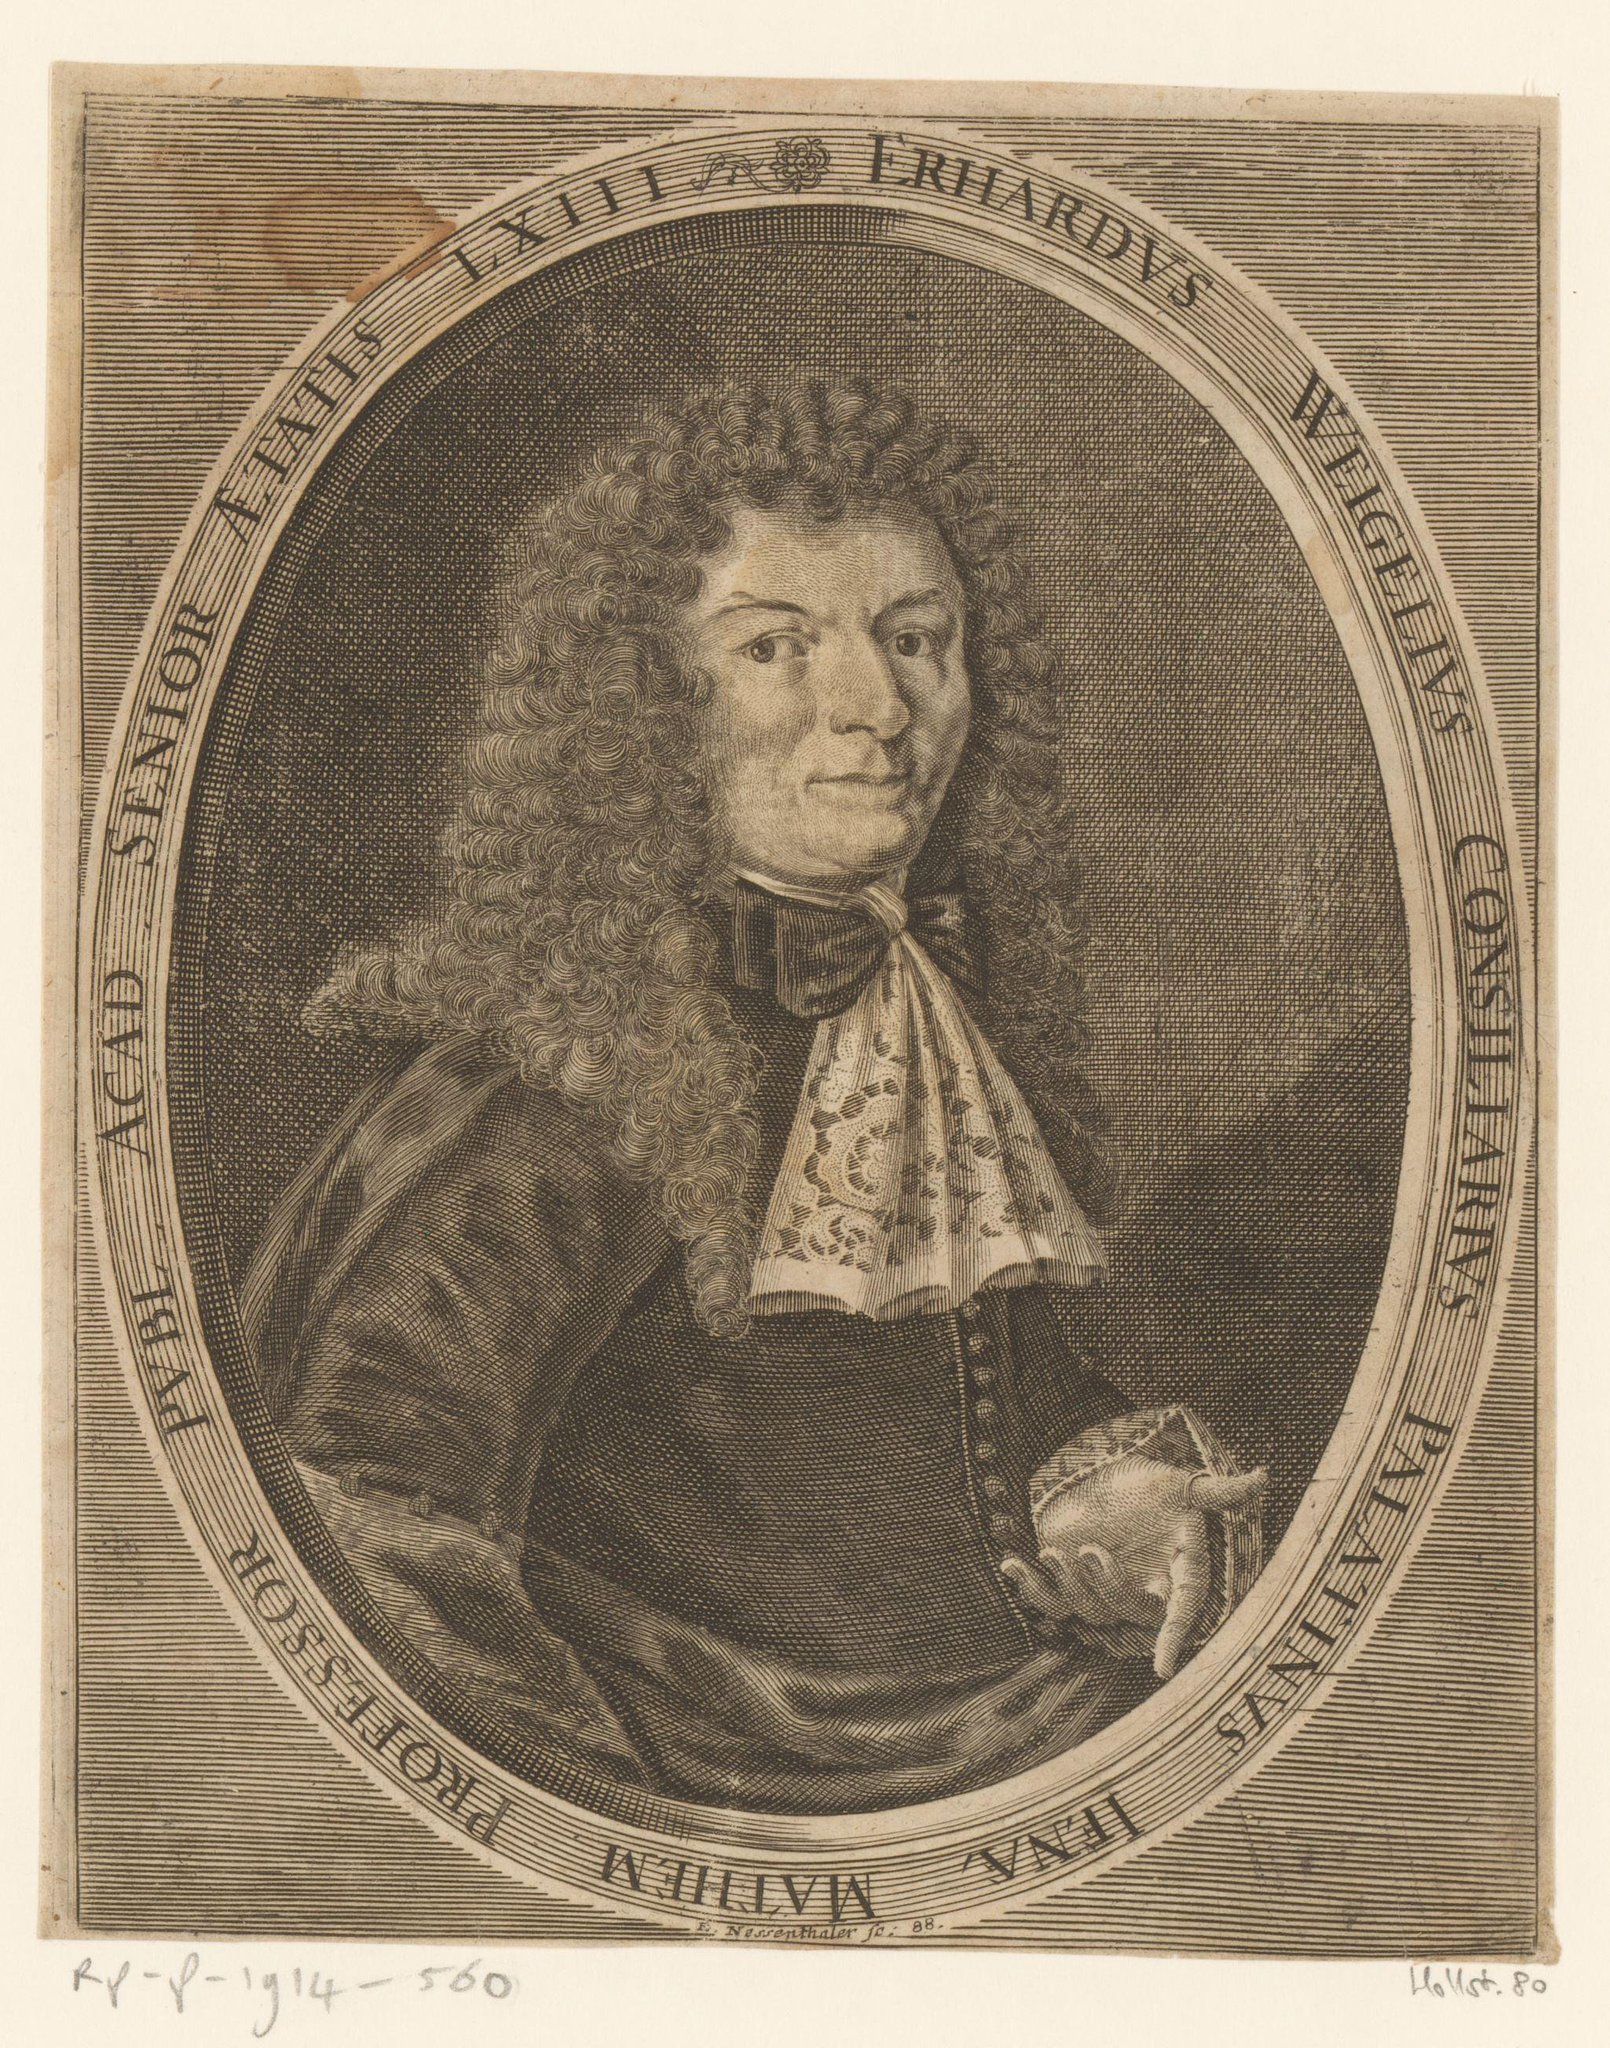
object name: print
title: Portret van Erhard Weigel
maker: elias nessenthaler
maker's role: print maker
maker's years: 1664-1714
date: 1688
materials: paper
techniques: engraving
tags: historical persons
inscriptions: collector's mark: Lugt 2228